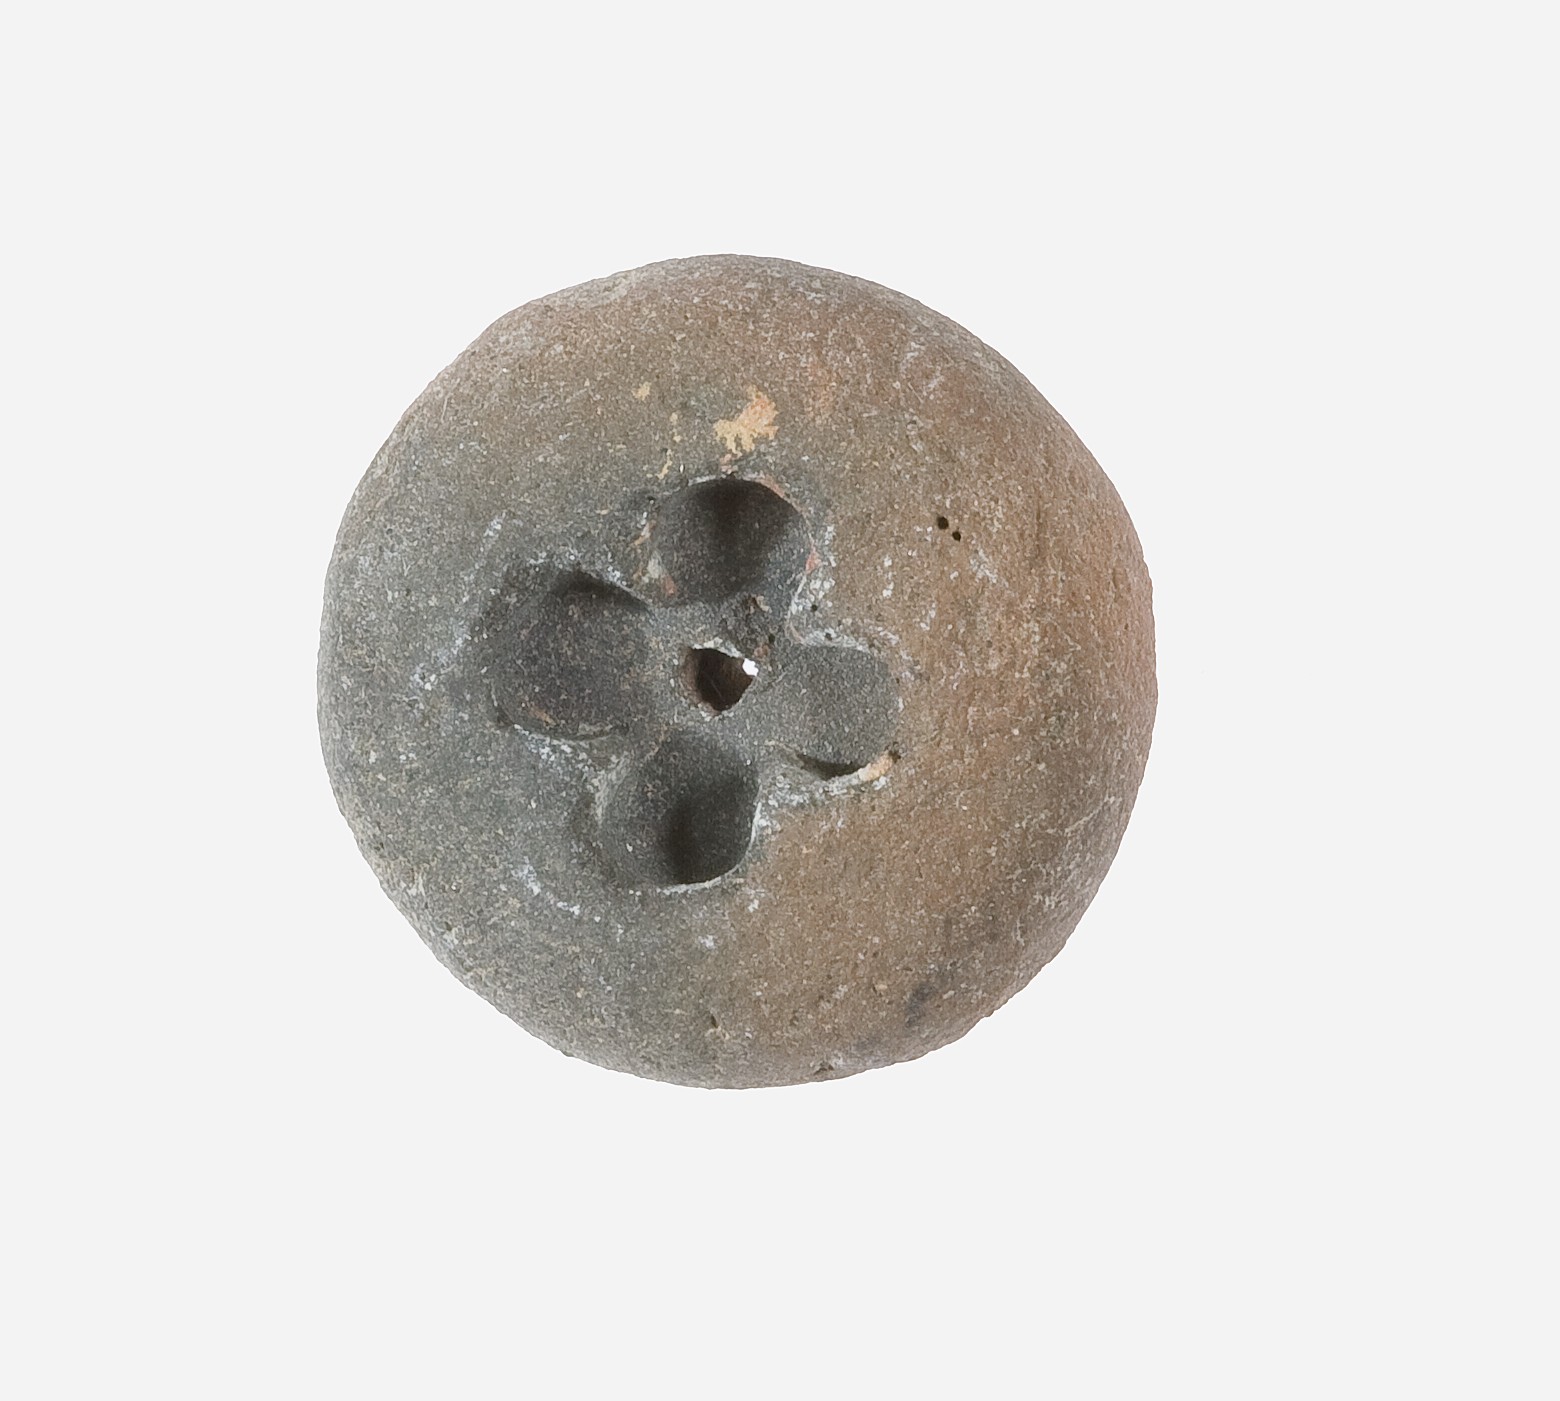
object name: mold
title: Quatrefoil Mold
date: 1390-1352 BCE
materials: pottery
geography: egypt